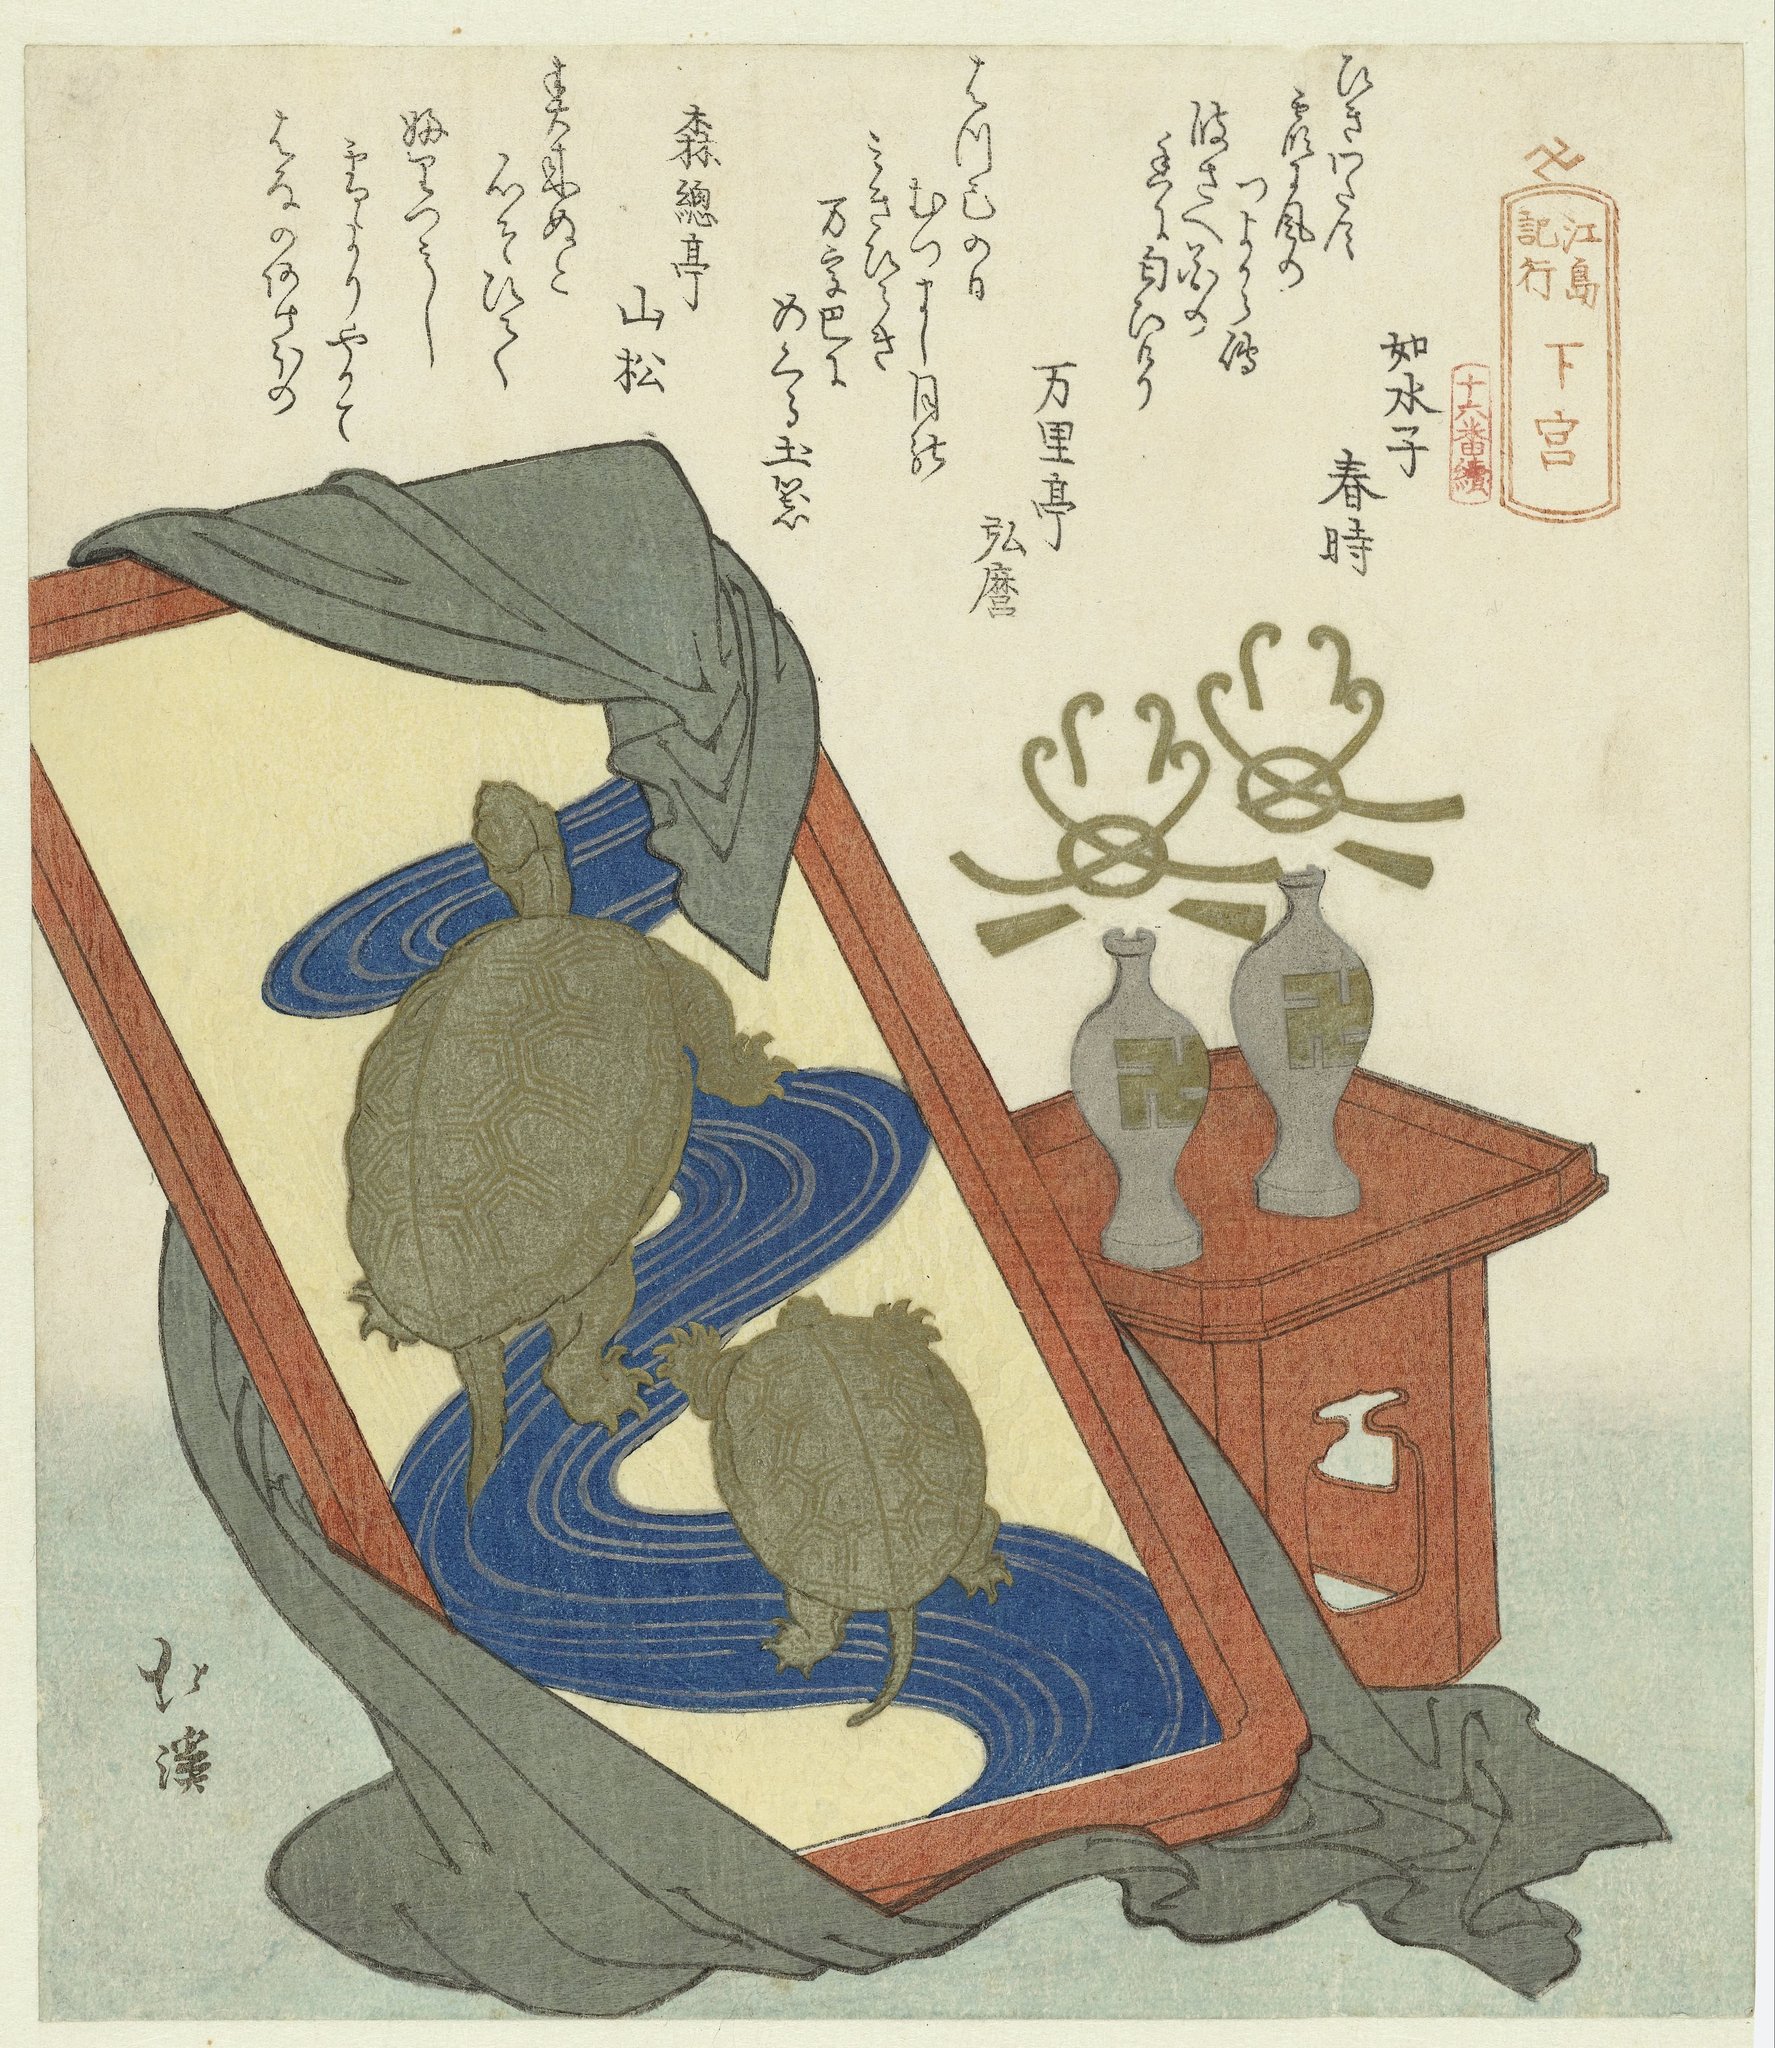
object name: surimono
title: Enoshima kikô - Jûrokubantsuzuki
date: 1833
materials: paper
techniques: blind stamped, woodcut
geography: japan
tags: tortoises, turtles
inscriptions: collector's mark, passe-partout, bottom left, printed: JABdH with a rooster., collector's mark, verso, stamped: Lugt 2228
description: Een surimono is een luxe uitgevoerde prent waarop beeld met één of meerdere gedichten gecombineerd is. Bij het drukken van een surimono werd vaak gebruik gemaakt van dikker papier, blinddruk en metaal pigmenten, zoals koper- en zilverpoeder. De prenten werden vaak in opdracht van dichters gemaakt en als exclusief geschenk aan vrienden en relaties gegeven.